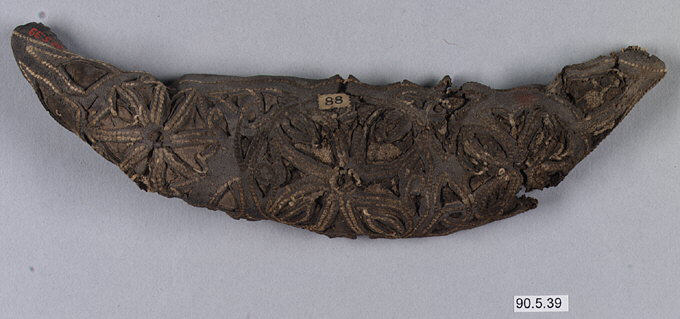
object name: coiffure support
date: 201-700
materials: leather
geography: egypt